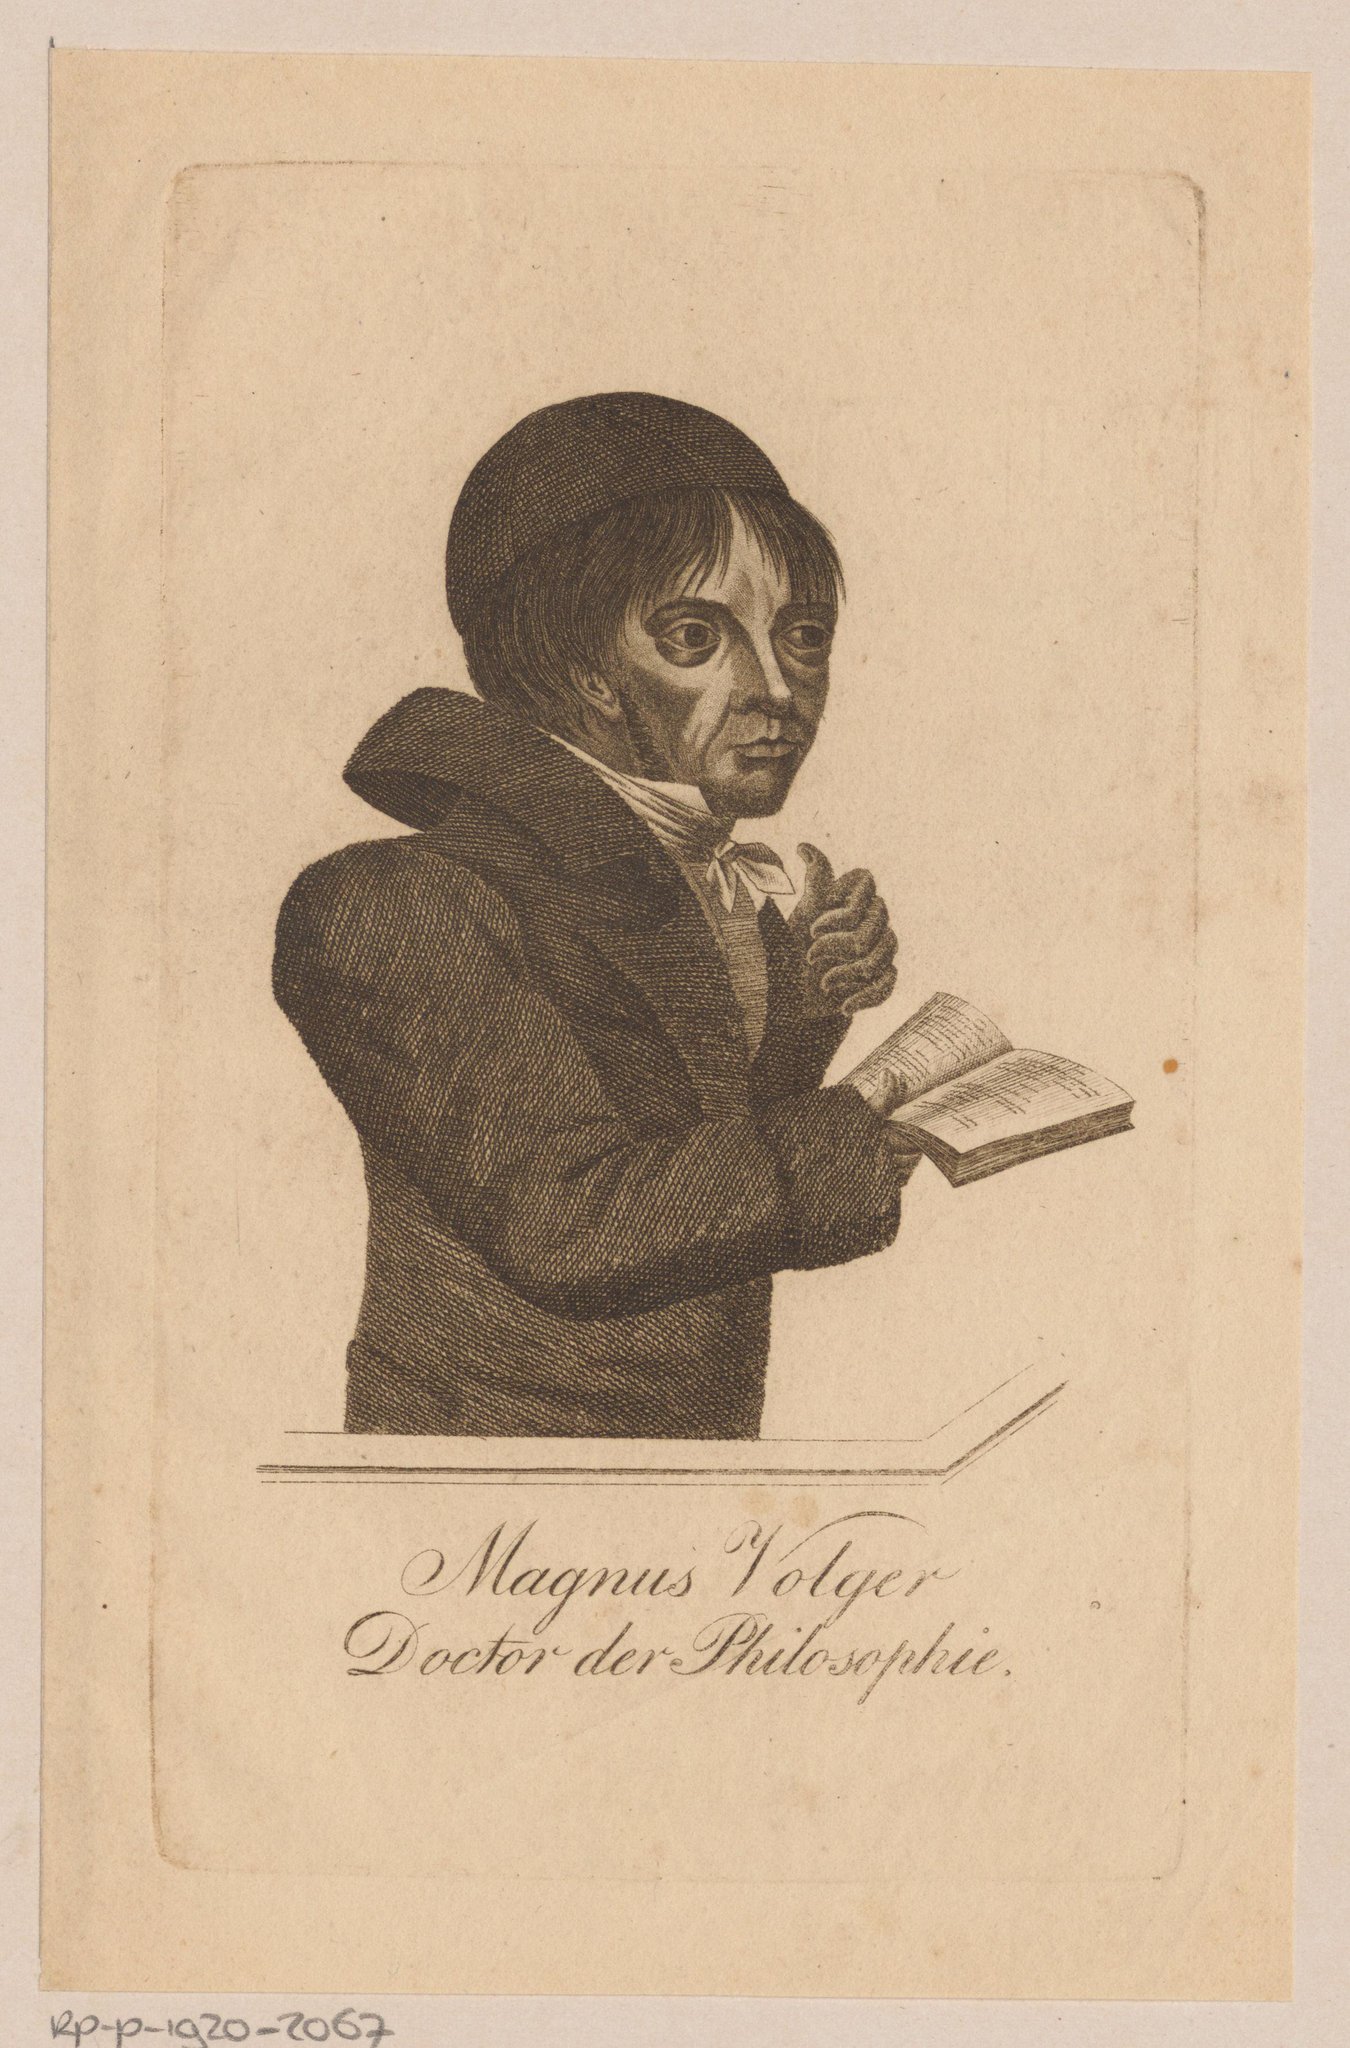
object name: print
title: Portret van Heinrich Friedrich Magnus Volger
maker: Anonymous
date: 1820-1850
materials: paper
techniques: etching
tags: germany, scholar, philosopher, historical persons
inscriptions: collector's mark: Lugt 2228